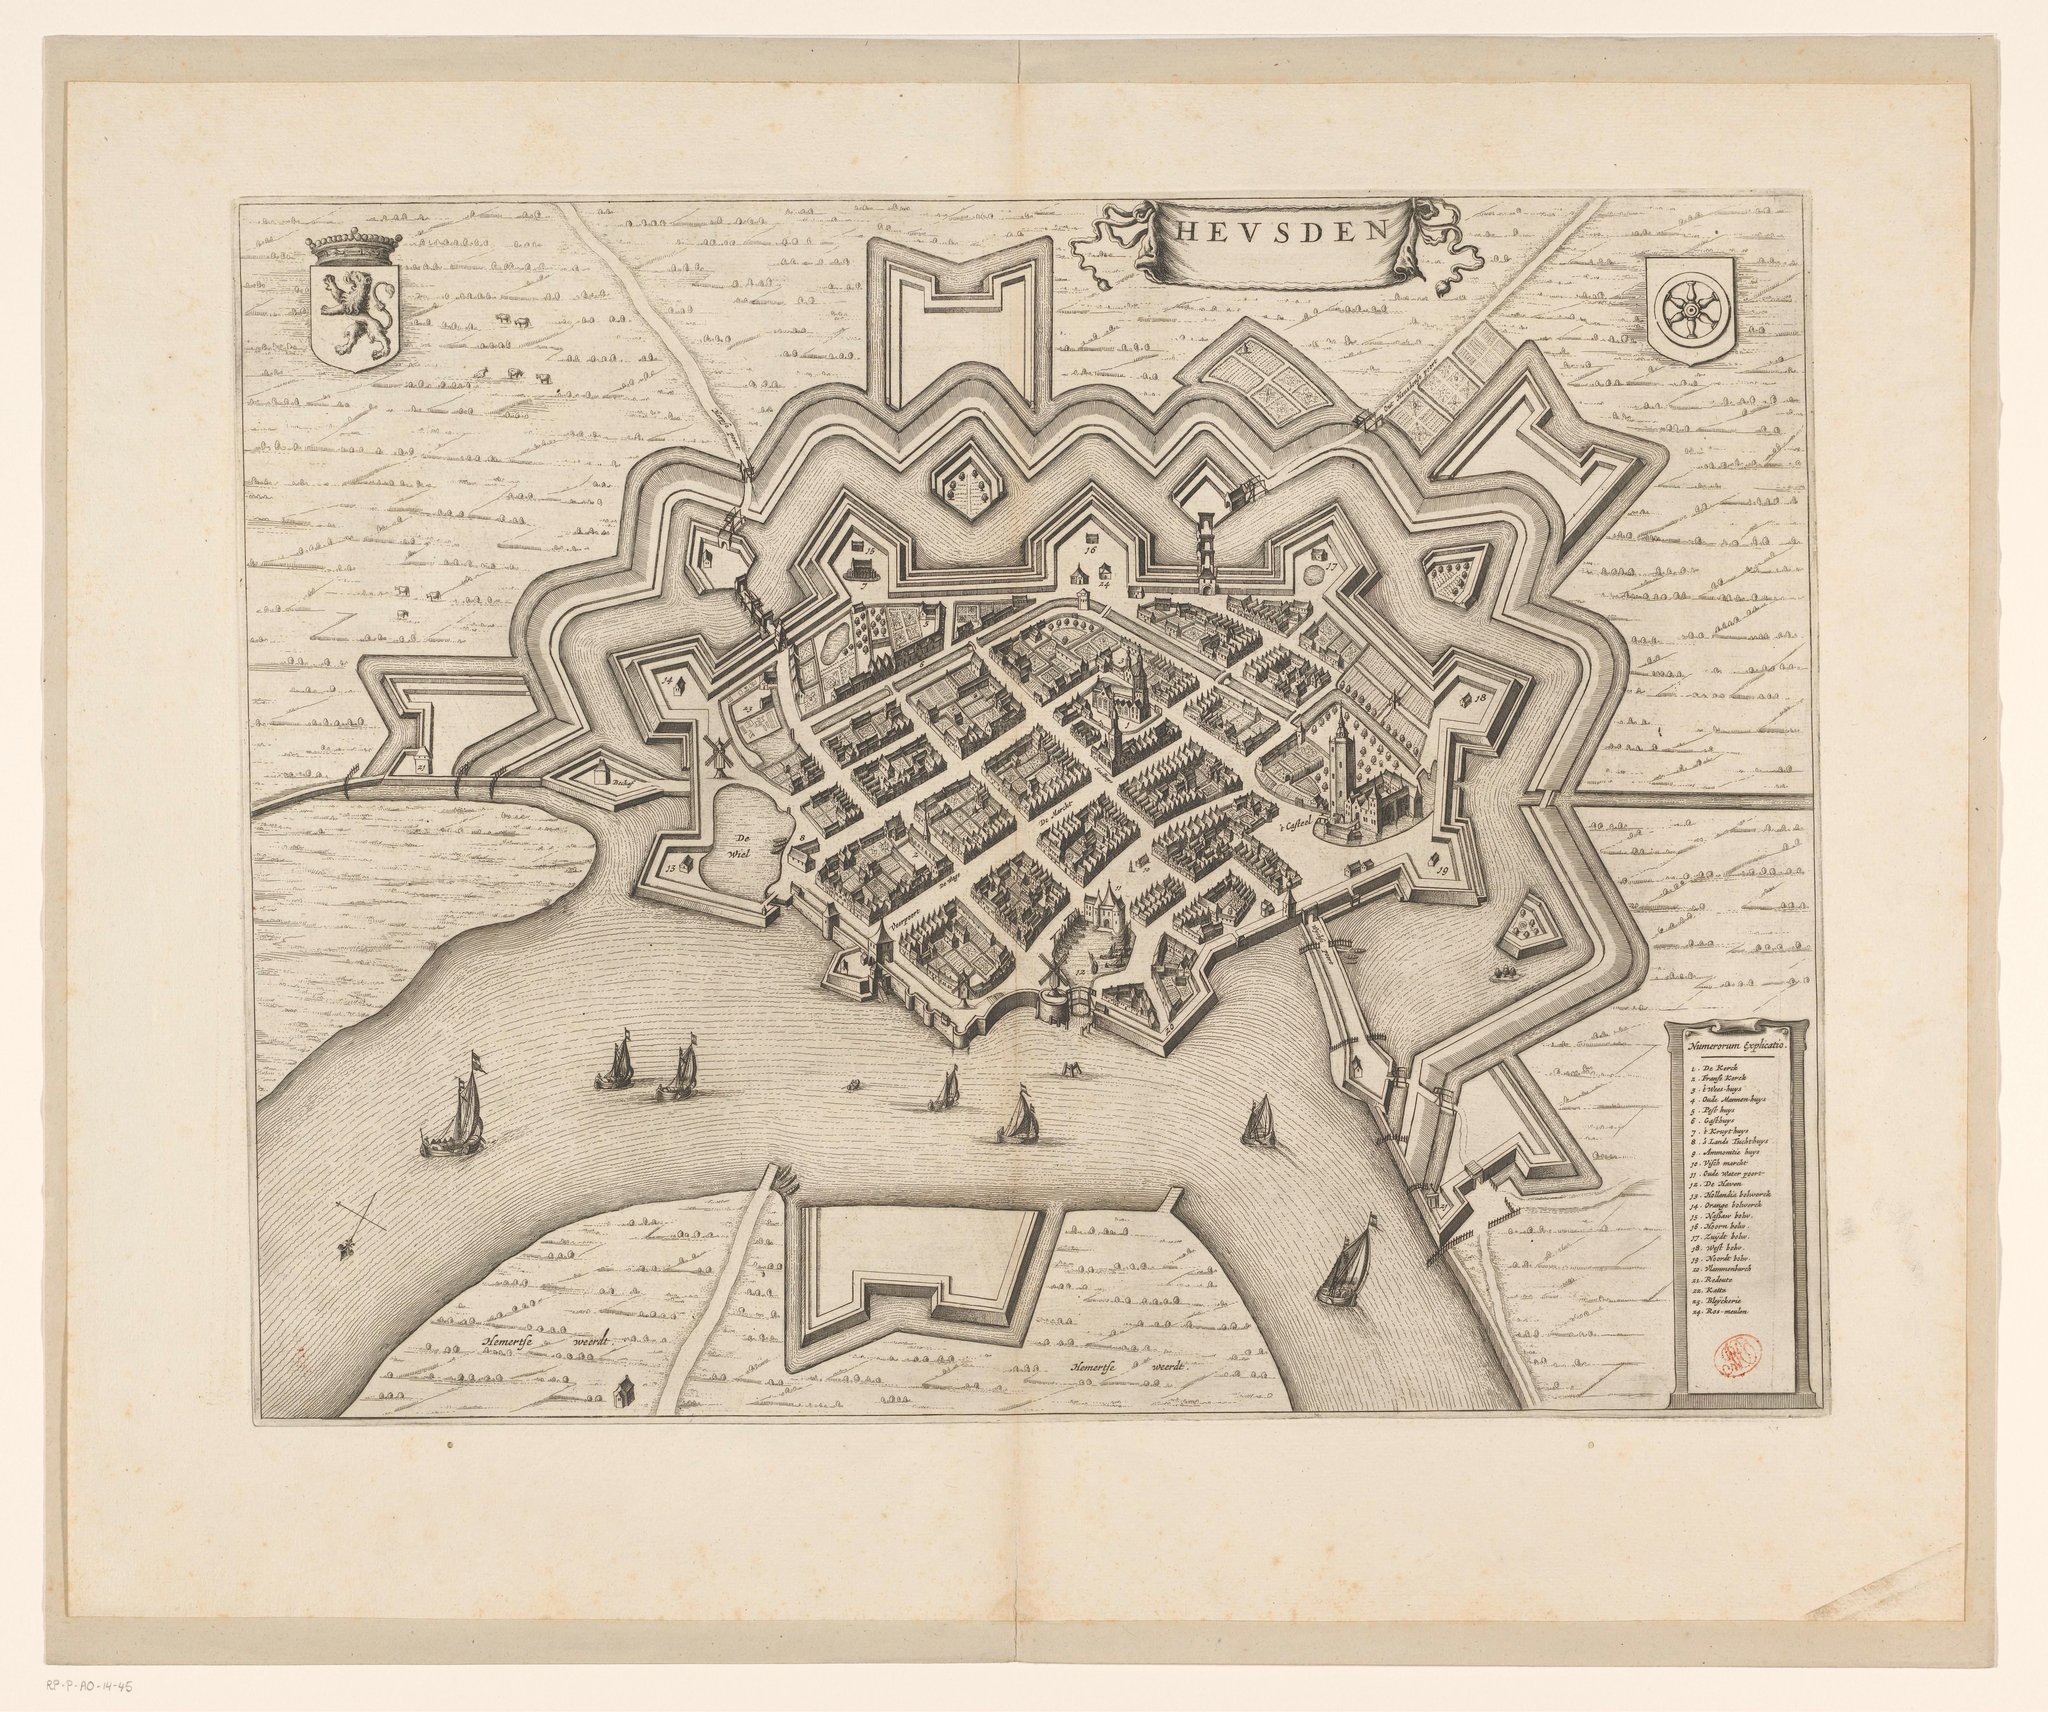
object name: area plan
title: Plattegrond van Heusden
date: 1652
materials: paper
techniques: engraving, etching, letterpress printing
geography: amsterdam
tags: coat of arms (as symbol of the state, etc.) (+ city; municipal), maps of cities, coat of arms (as symbol of the state, etc.) (+ province; provincial)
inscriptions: collector's mark: Lugt 195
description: Plattegrond in vogelvluchtperspectief. Linksboven het wapen van Holland, rechts het midden de titel en rechtsboven het wapen van Heusden. Rechtsonder de legenda 1-14. Op verso Nederlandse tekst.